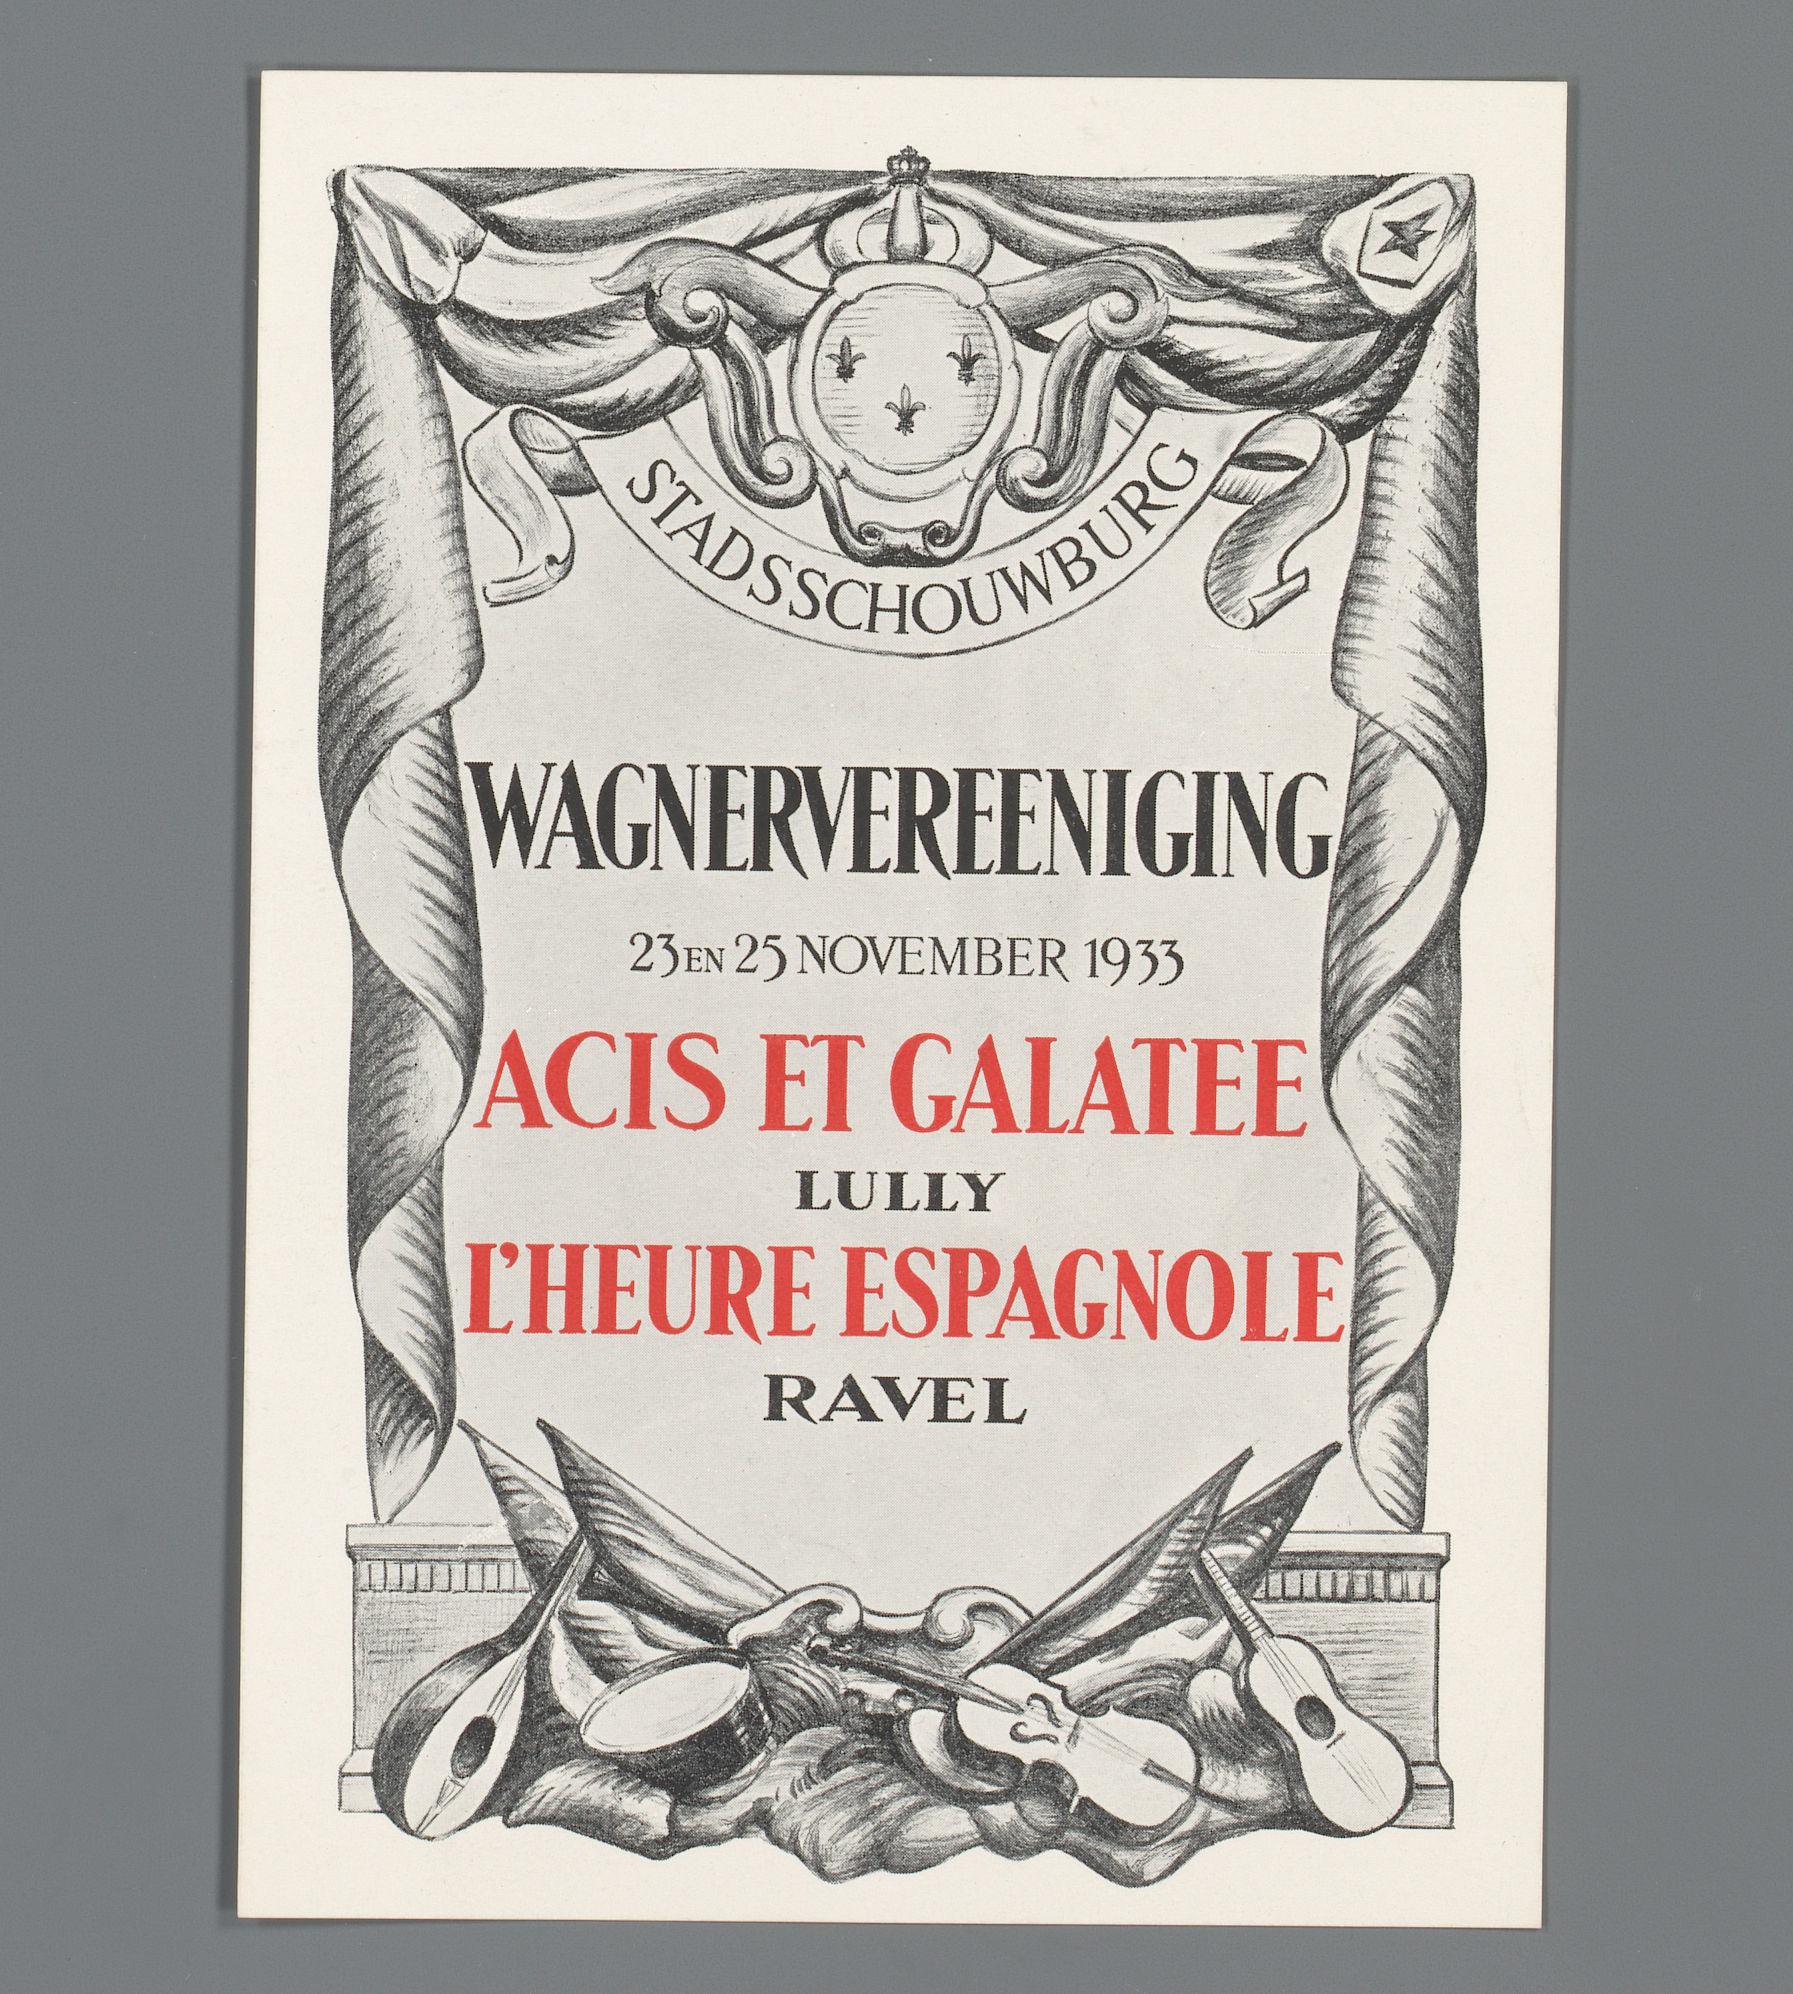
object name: photomechanical print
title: Wagnervereeniging Acis et Galatee Lully L'Heure Espagnole Ravel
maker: Anonymous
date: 1911-1933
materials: paper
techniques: autotype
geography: netherlands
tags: advertising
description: Reclamebiljet voor uitvoering door de Wagnervereeniging van Acis et Galatee (Lully) en L'Heure Espagnole (Ravel), Stadsschouwburg Amsterdam, 23 en 25 november 1933.